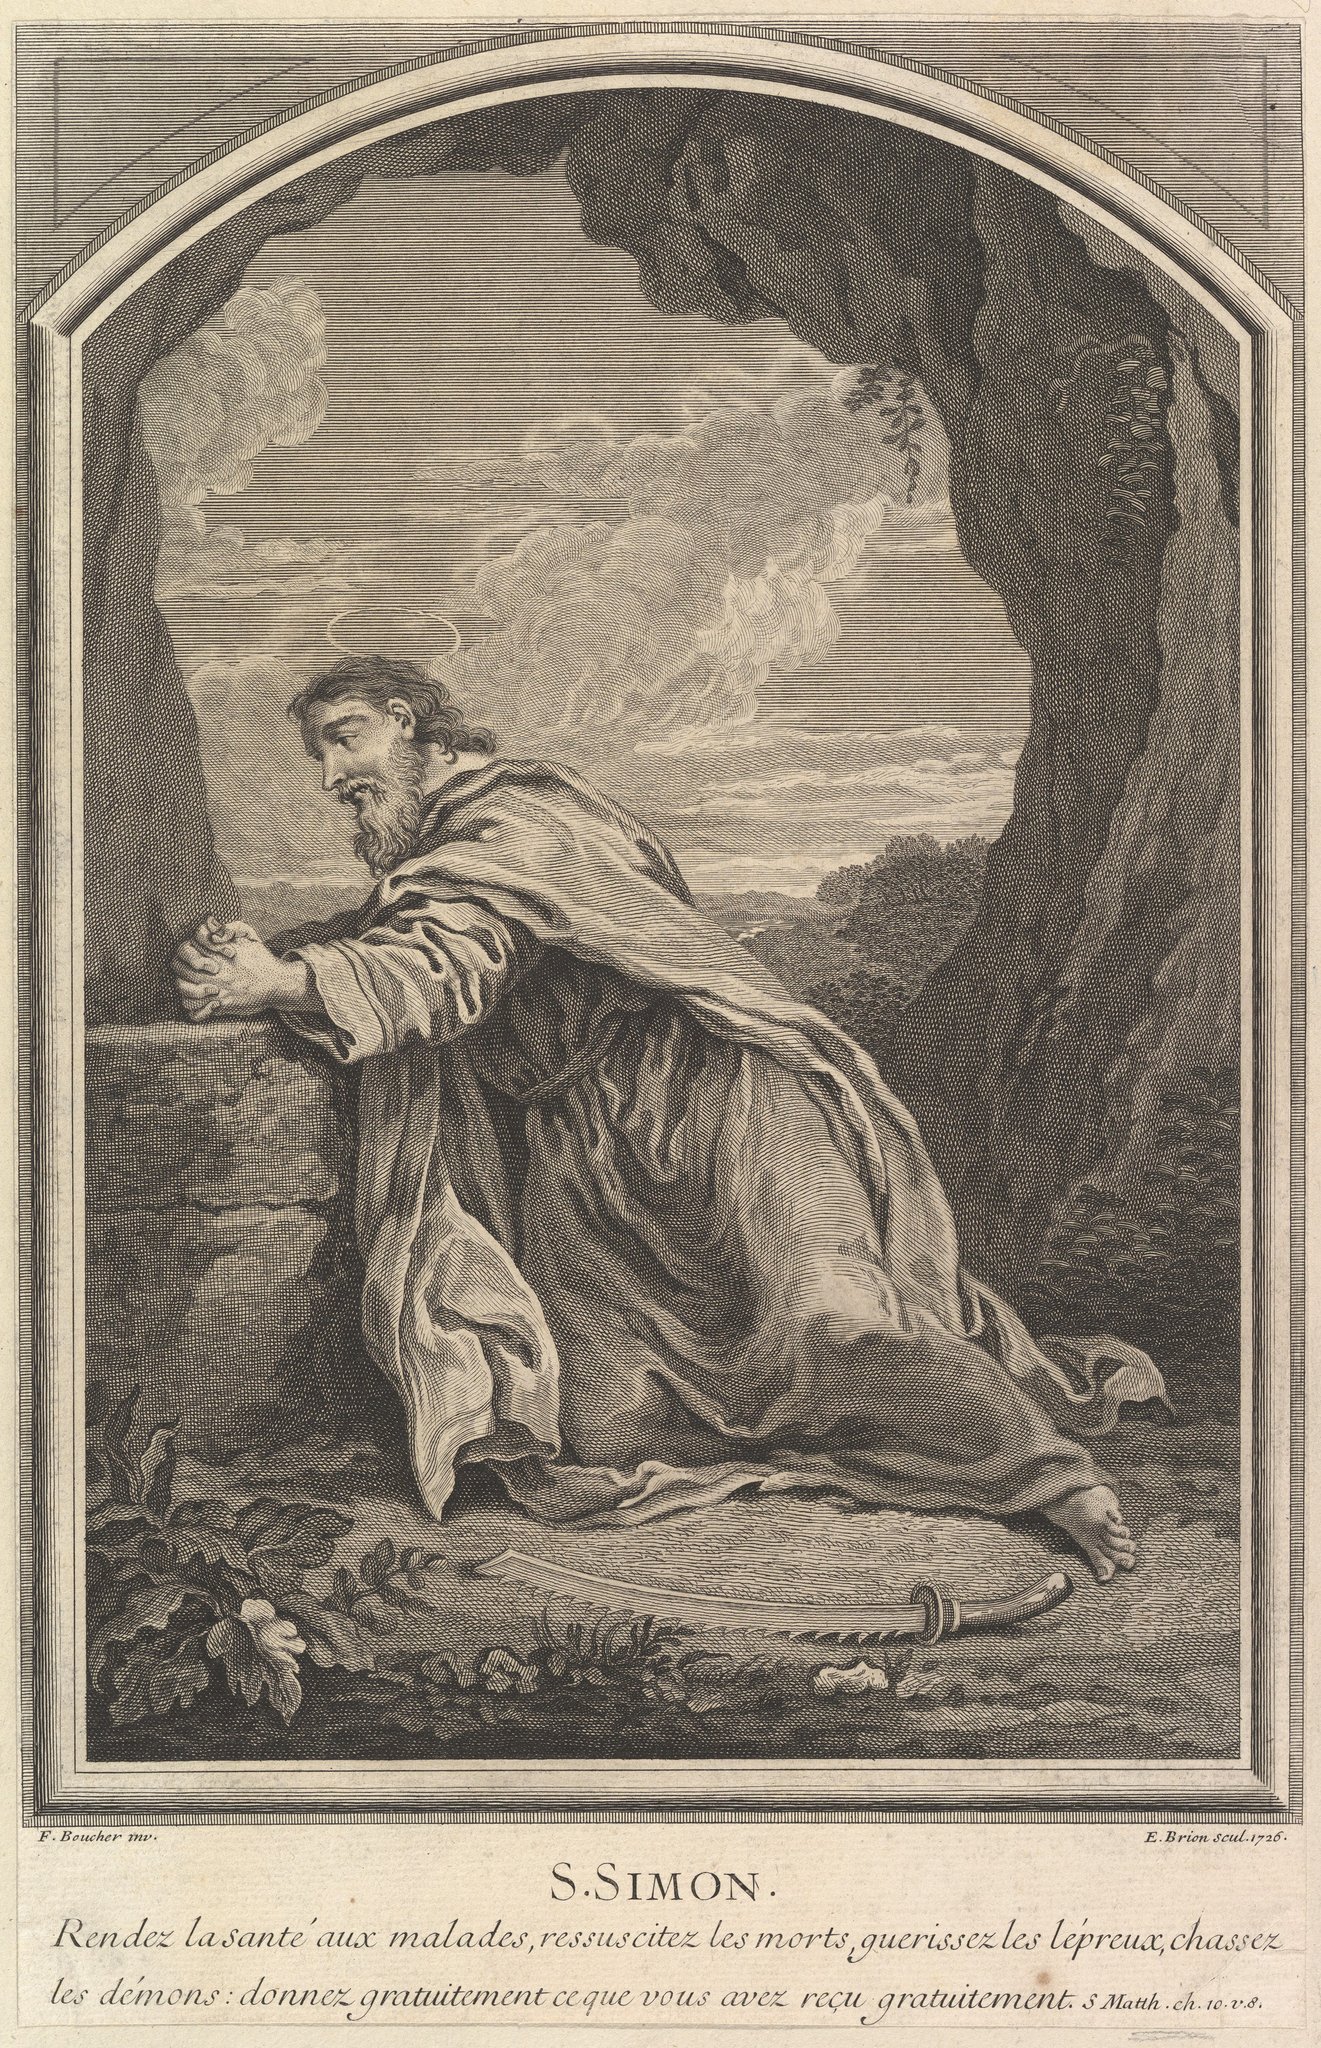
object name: print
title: Saint Simon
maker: etienne brion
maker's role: artist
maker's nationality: french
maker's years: 1700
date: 1726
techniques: engraving, etching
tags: men,saints